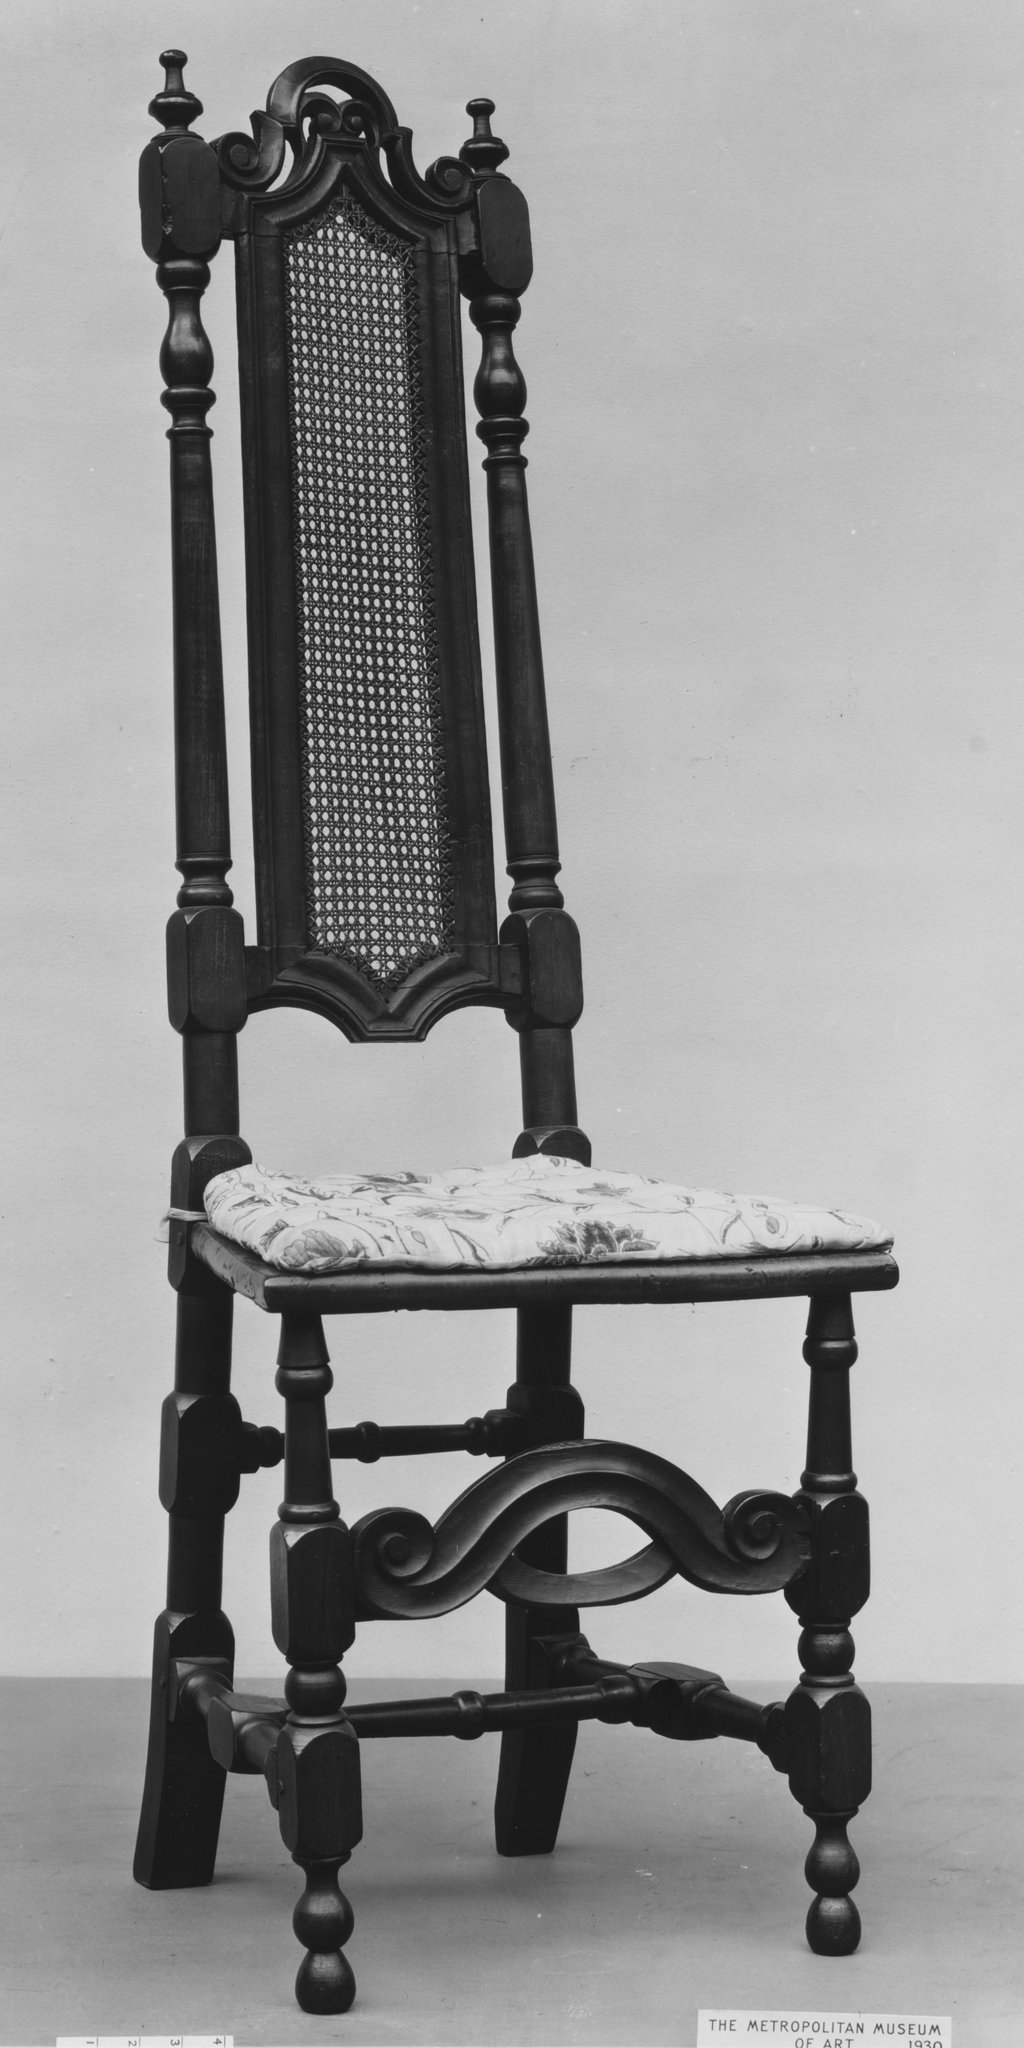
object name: side chair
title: Cane side chair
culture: british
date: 1690-1710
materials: wood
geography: england